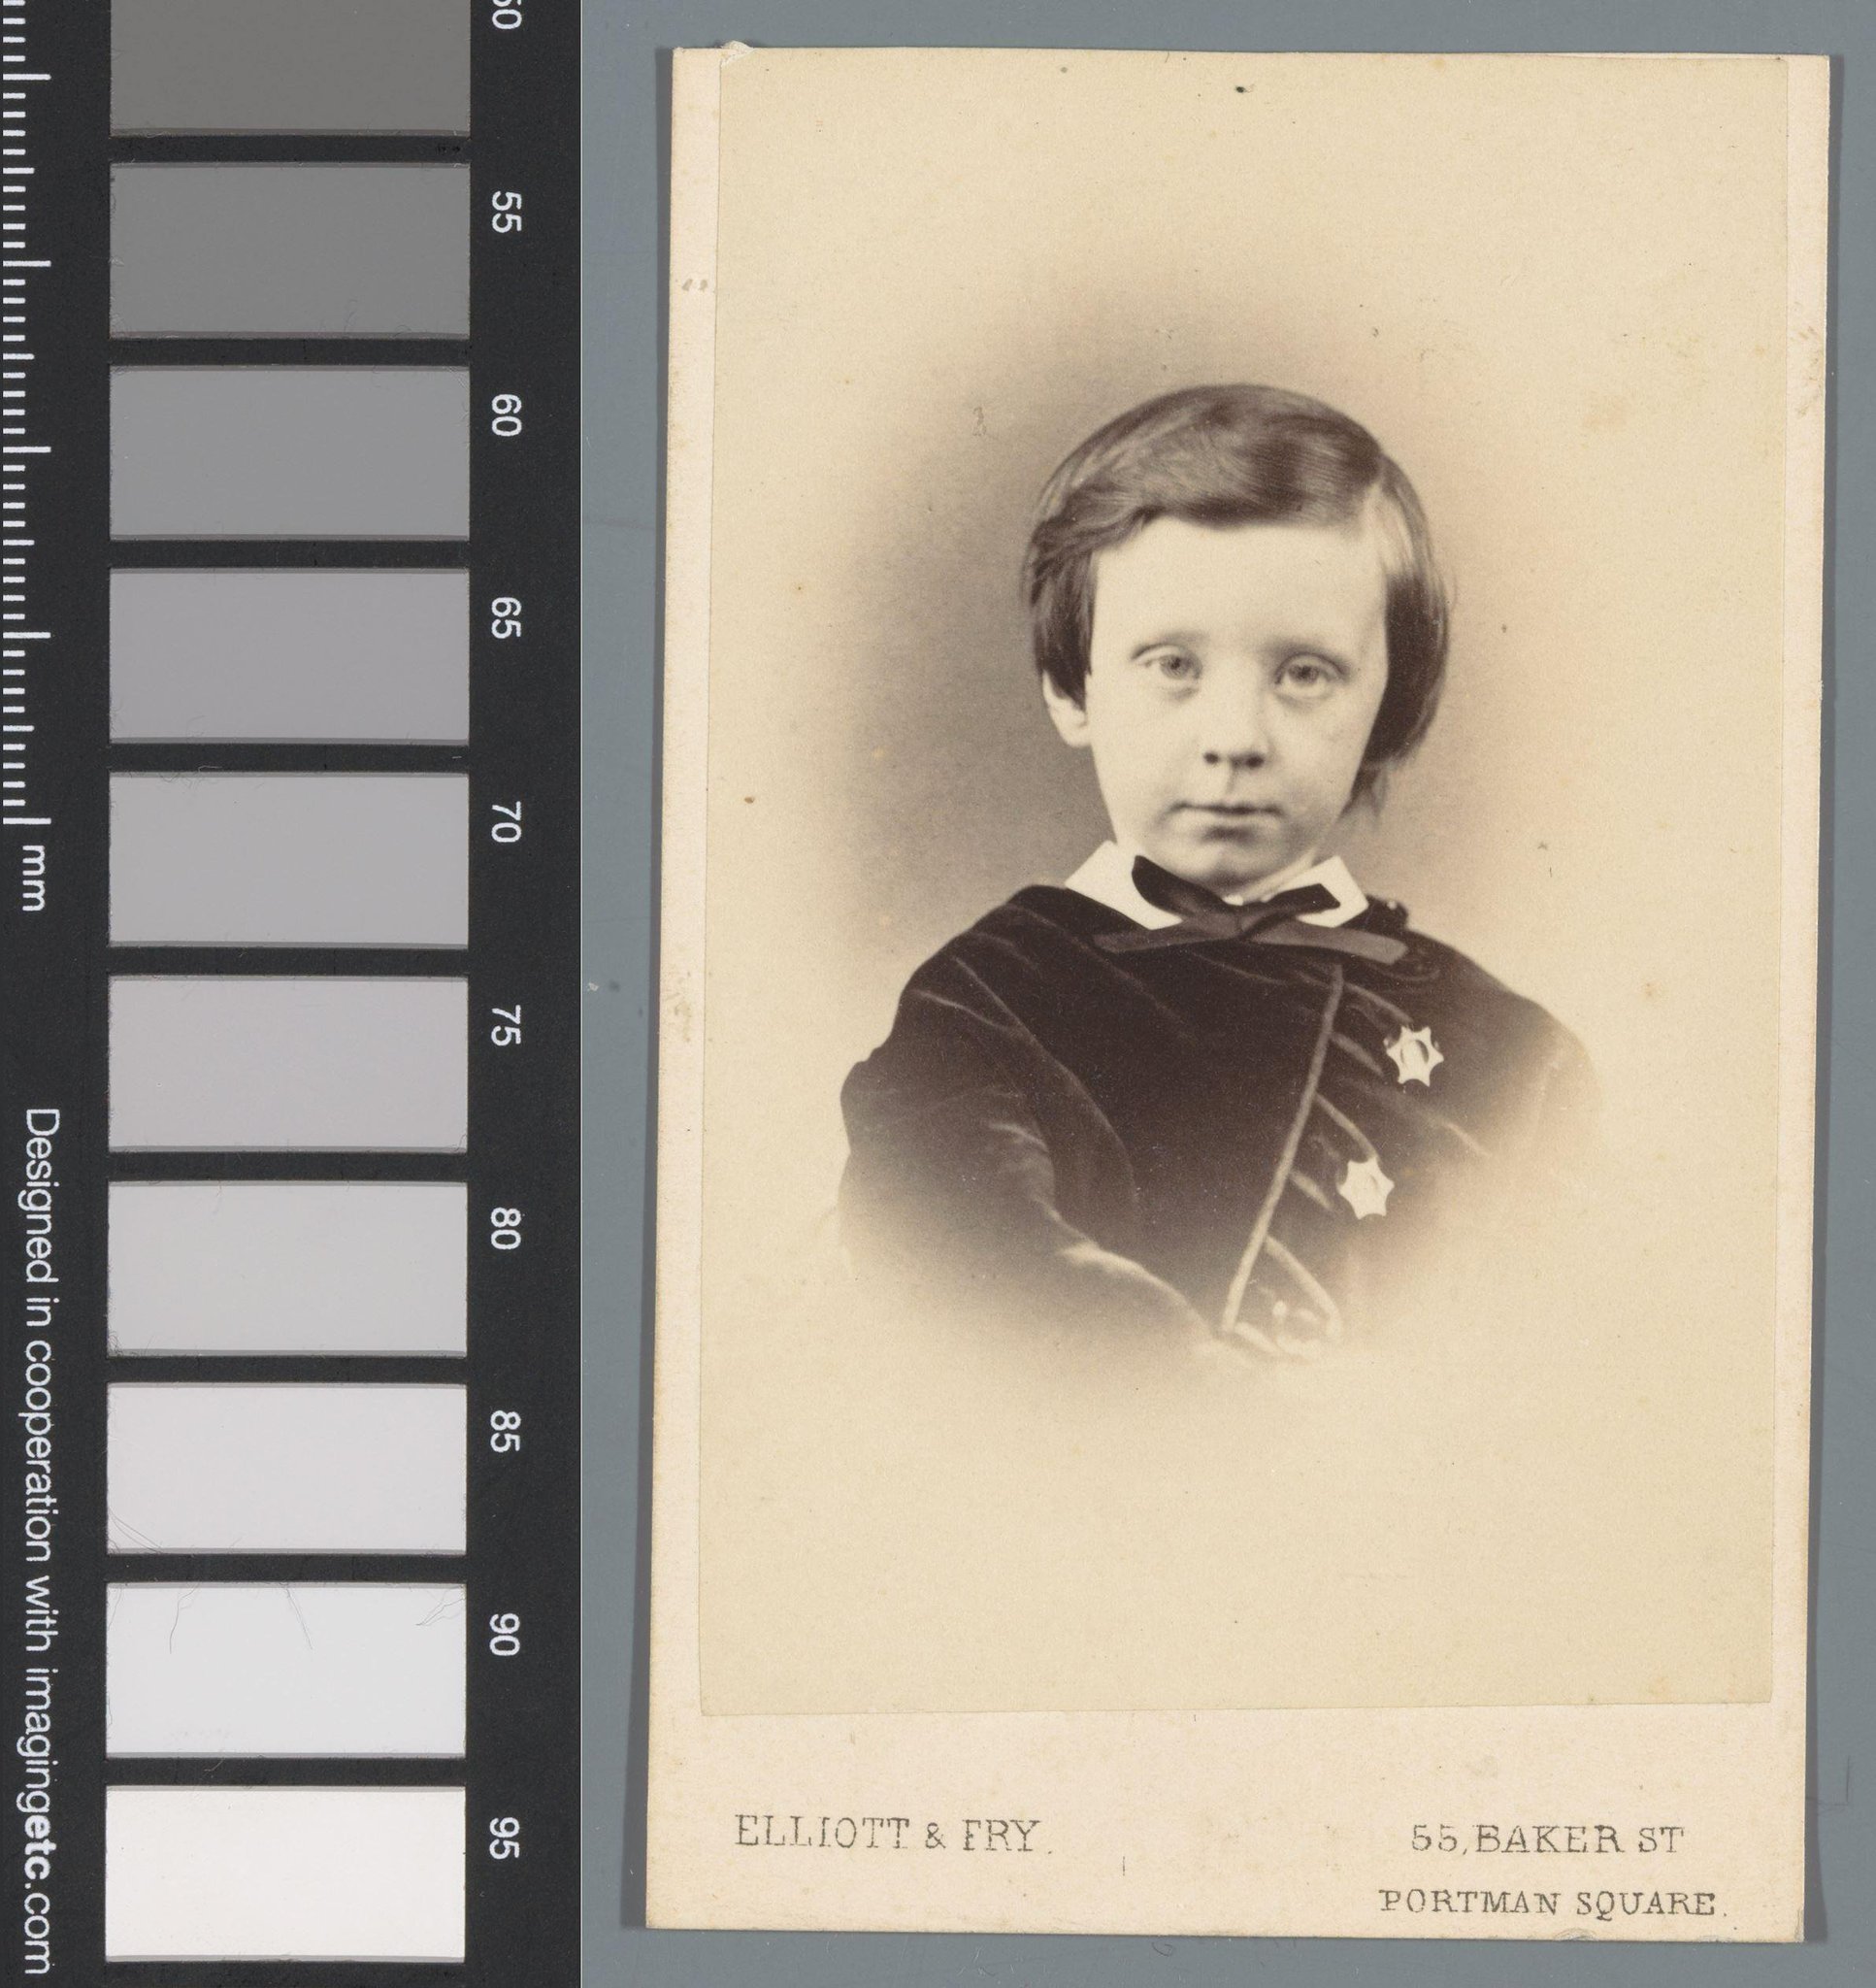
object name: carte de visite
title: Portret van een onbekende jongen, aangeduid als Percil Hutton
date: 1863-1887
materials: cardboard, paper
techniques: albumen print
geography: london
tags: boy (child between toddler and youth), historical persons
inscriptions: inscription: ‘EF/ ELLIOTT & FRY./ 55, BAKER STREET,/ PORTMAN SQUARE.’, inscription: ‘Percil hutton’